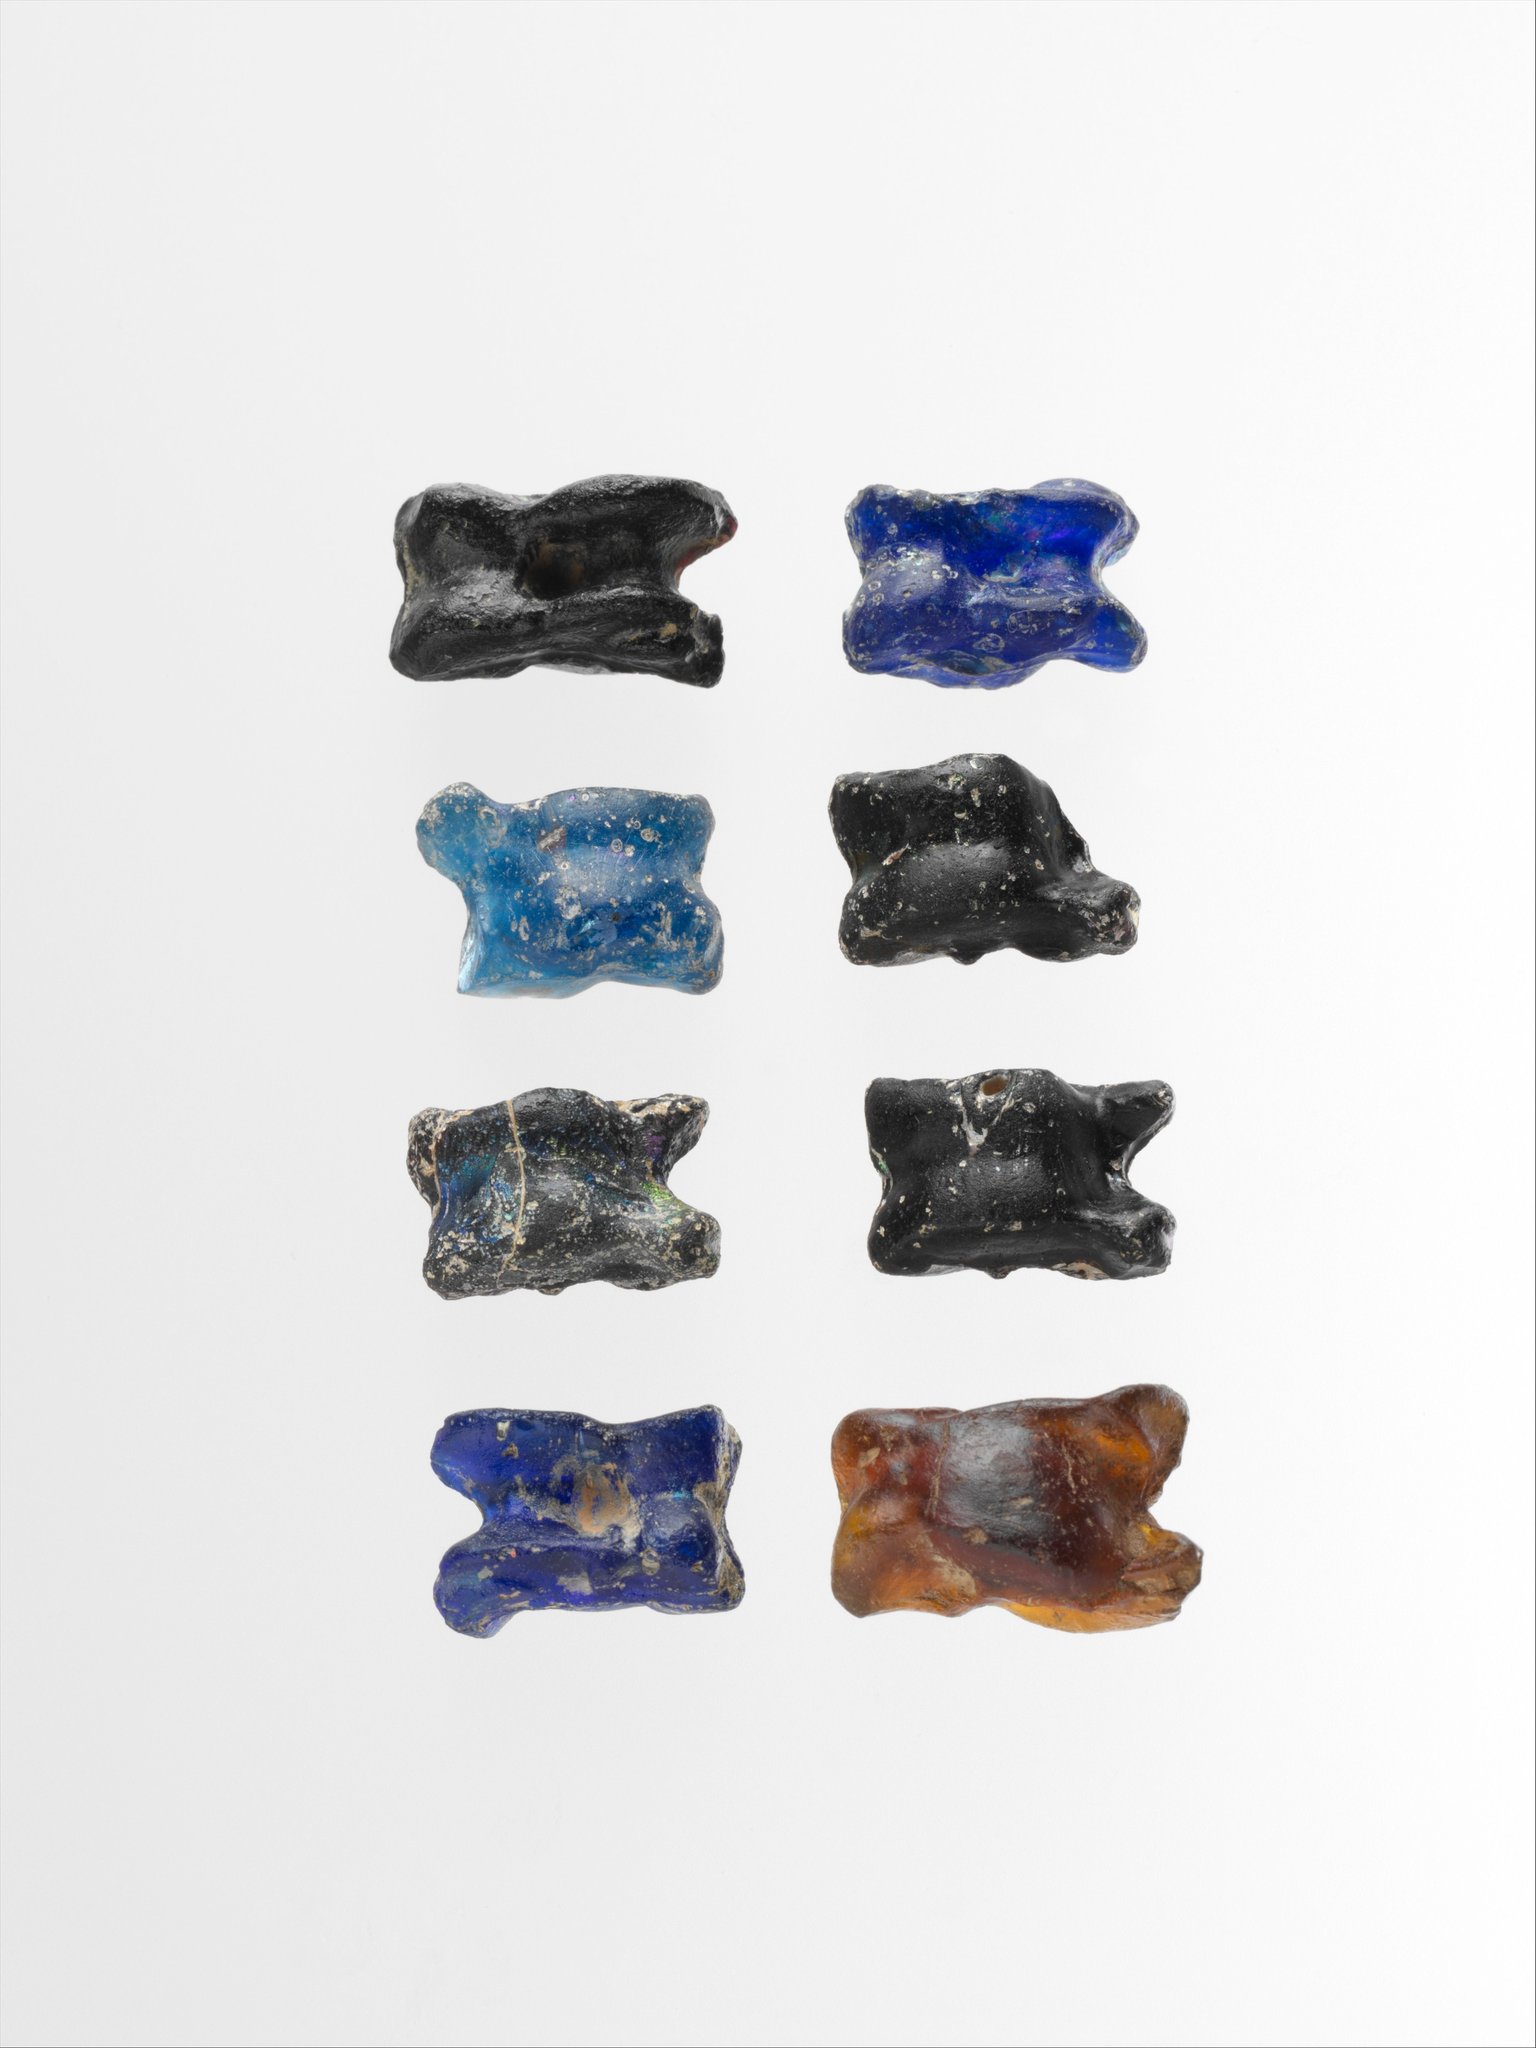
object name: astragal, group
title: Group of eight glass astragali (knucklebones)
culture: greek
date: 300-101 BCE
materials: glass